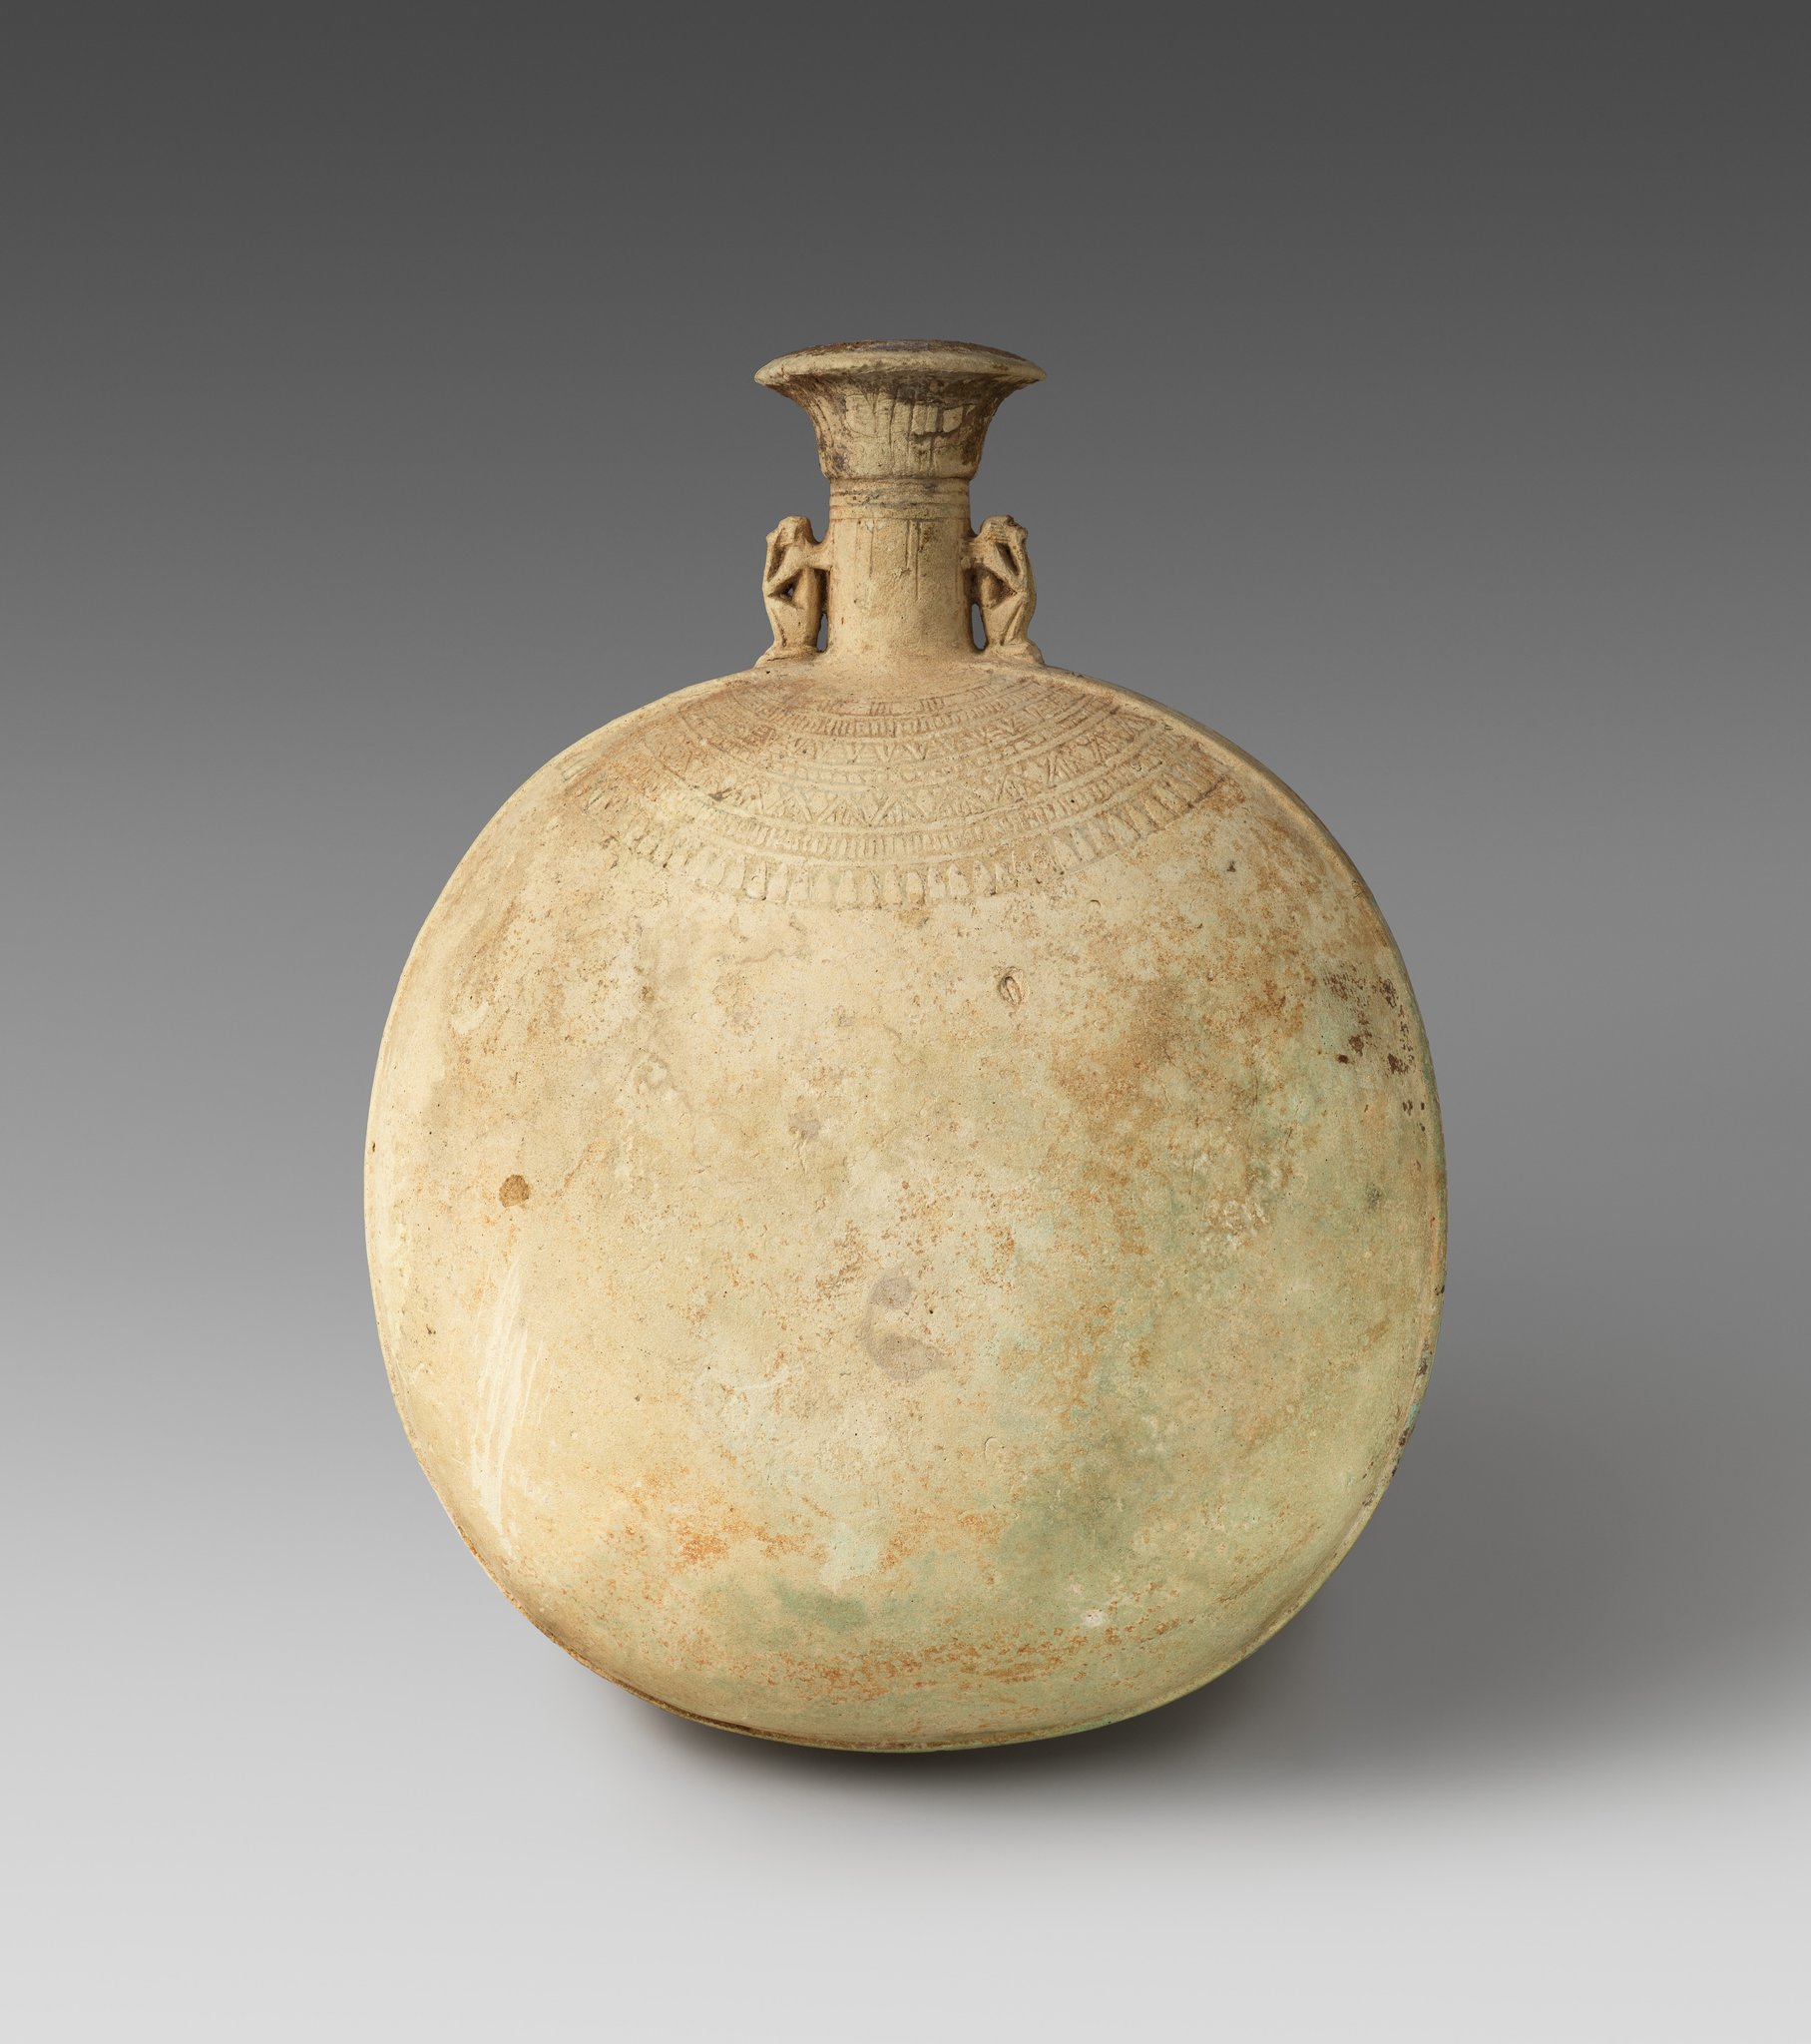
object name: lentoid bottle, new year's bottle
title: Lentoid Bottle ("New Year's Bottle")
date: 664-332 BCE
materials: faience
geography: egypt